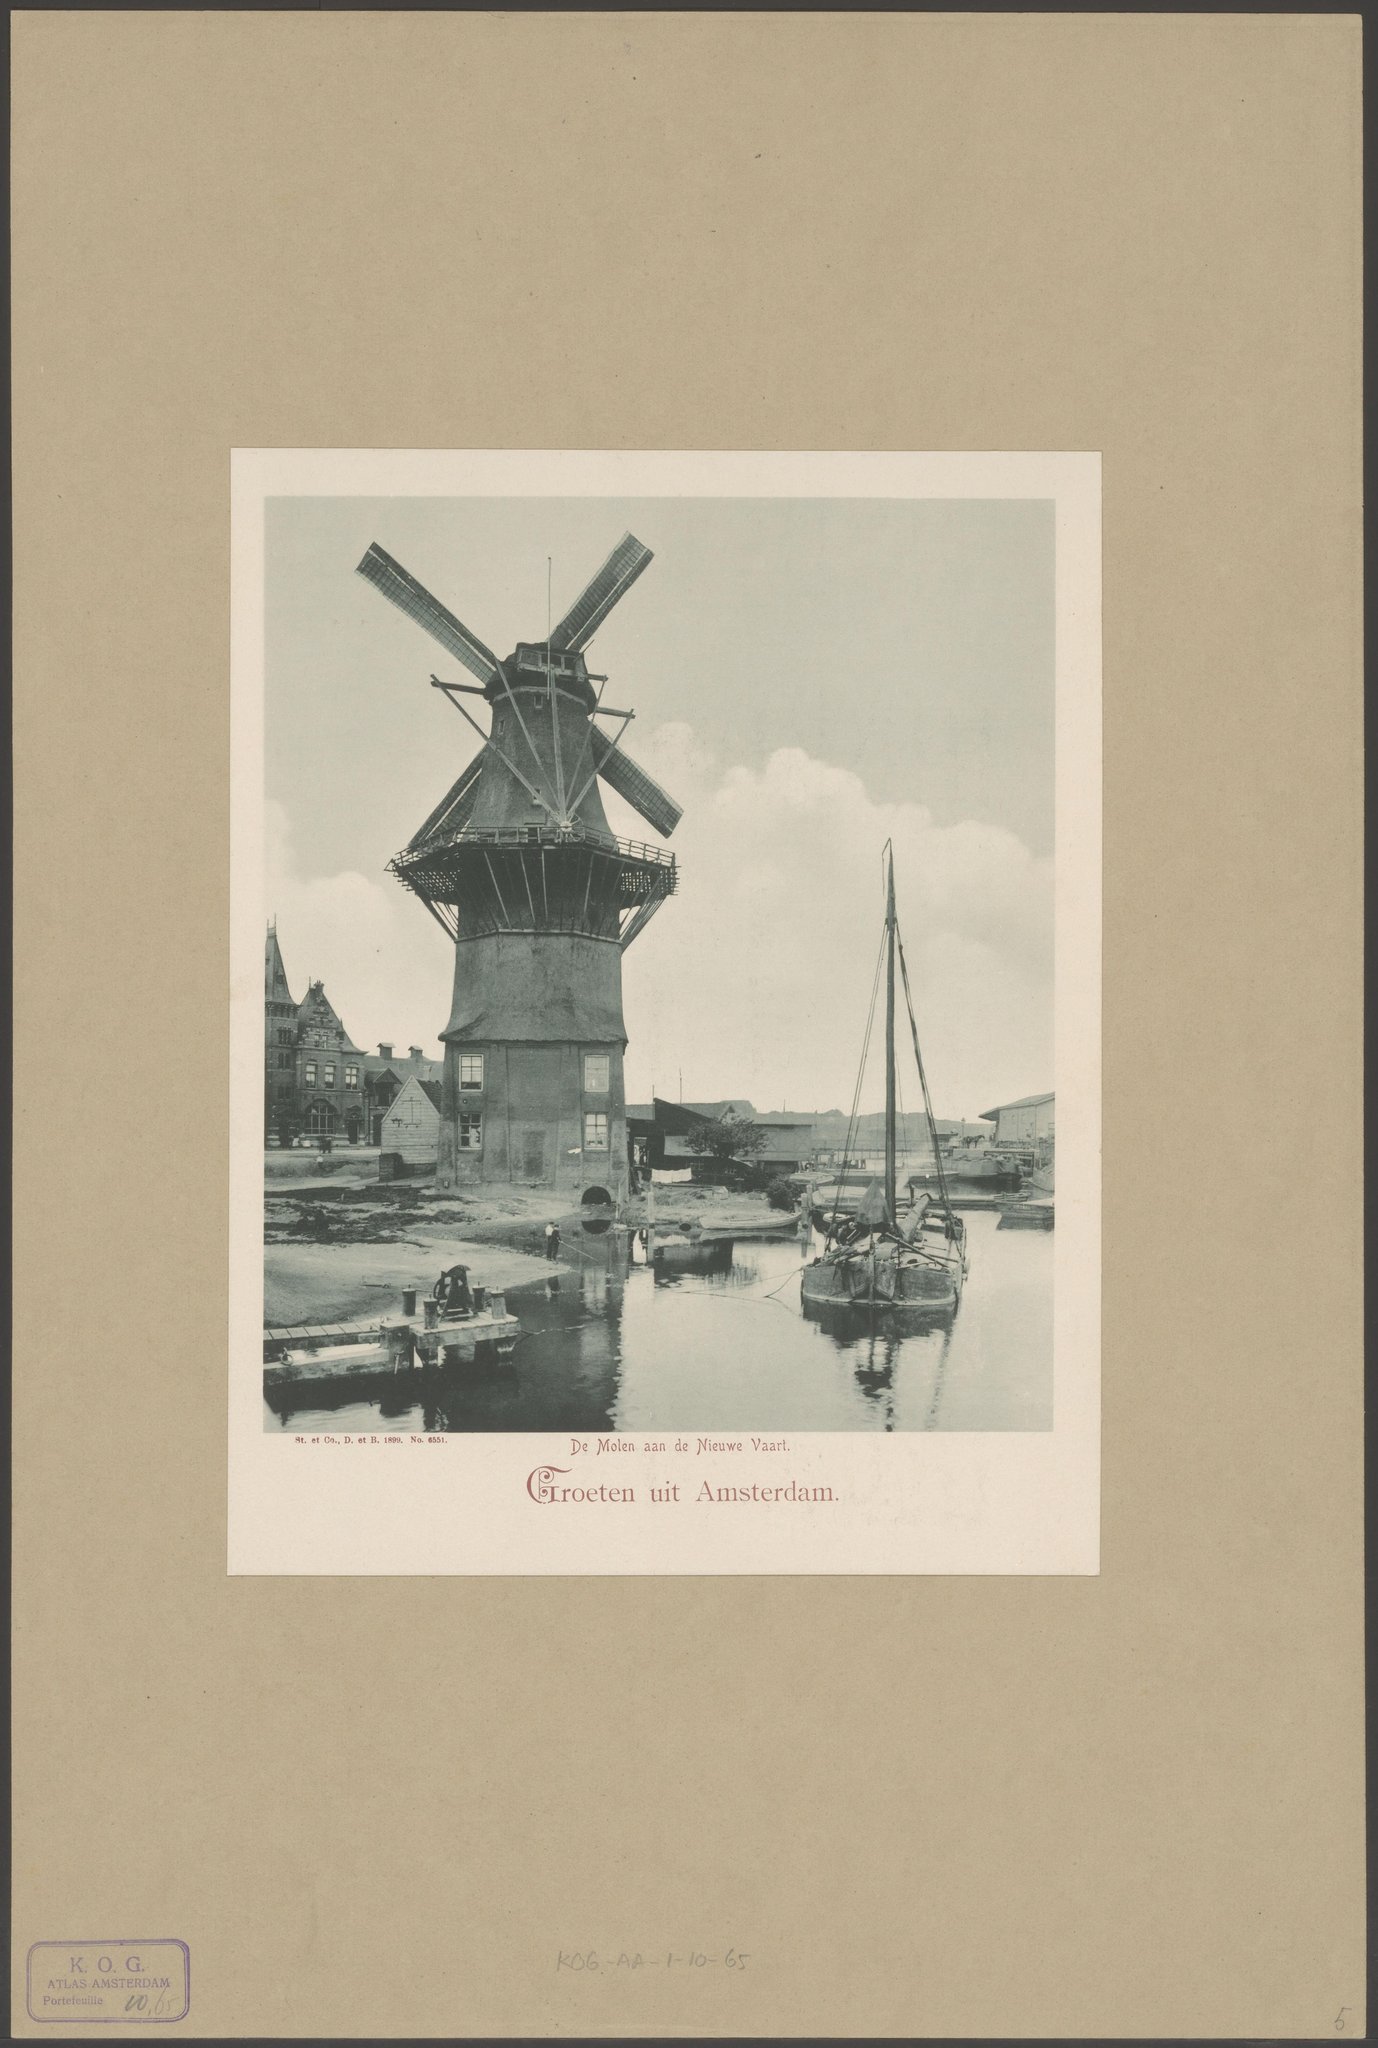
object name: ansichtkaart, prentbriefkaart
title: Gezicht op een molen aan de Nieuwe Vaart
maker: Anonymous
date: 1899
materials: cardboard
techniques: photograph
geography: germany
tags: sailing-ship, sailing-boat, city-view in general; 'veduta', canal, windmill in landscape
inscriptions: collector's mark: ‘10,65’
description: Onderwerpsrubriek binnen de Atlas Amsterdam: Nieuwe Grachtje, Nieuwendijk, Nieuwe Vaart, Nieuwlandsstraat (Pieter).